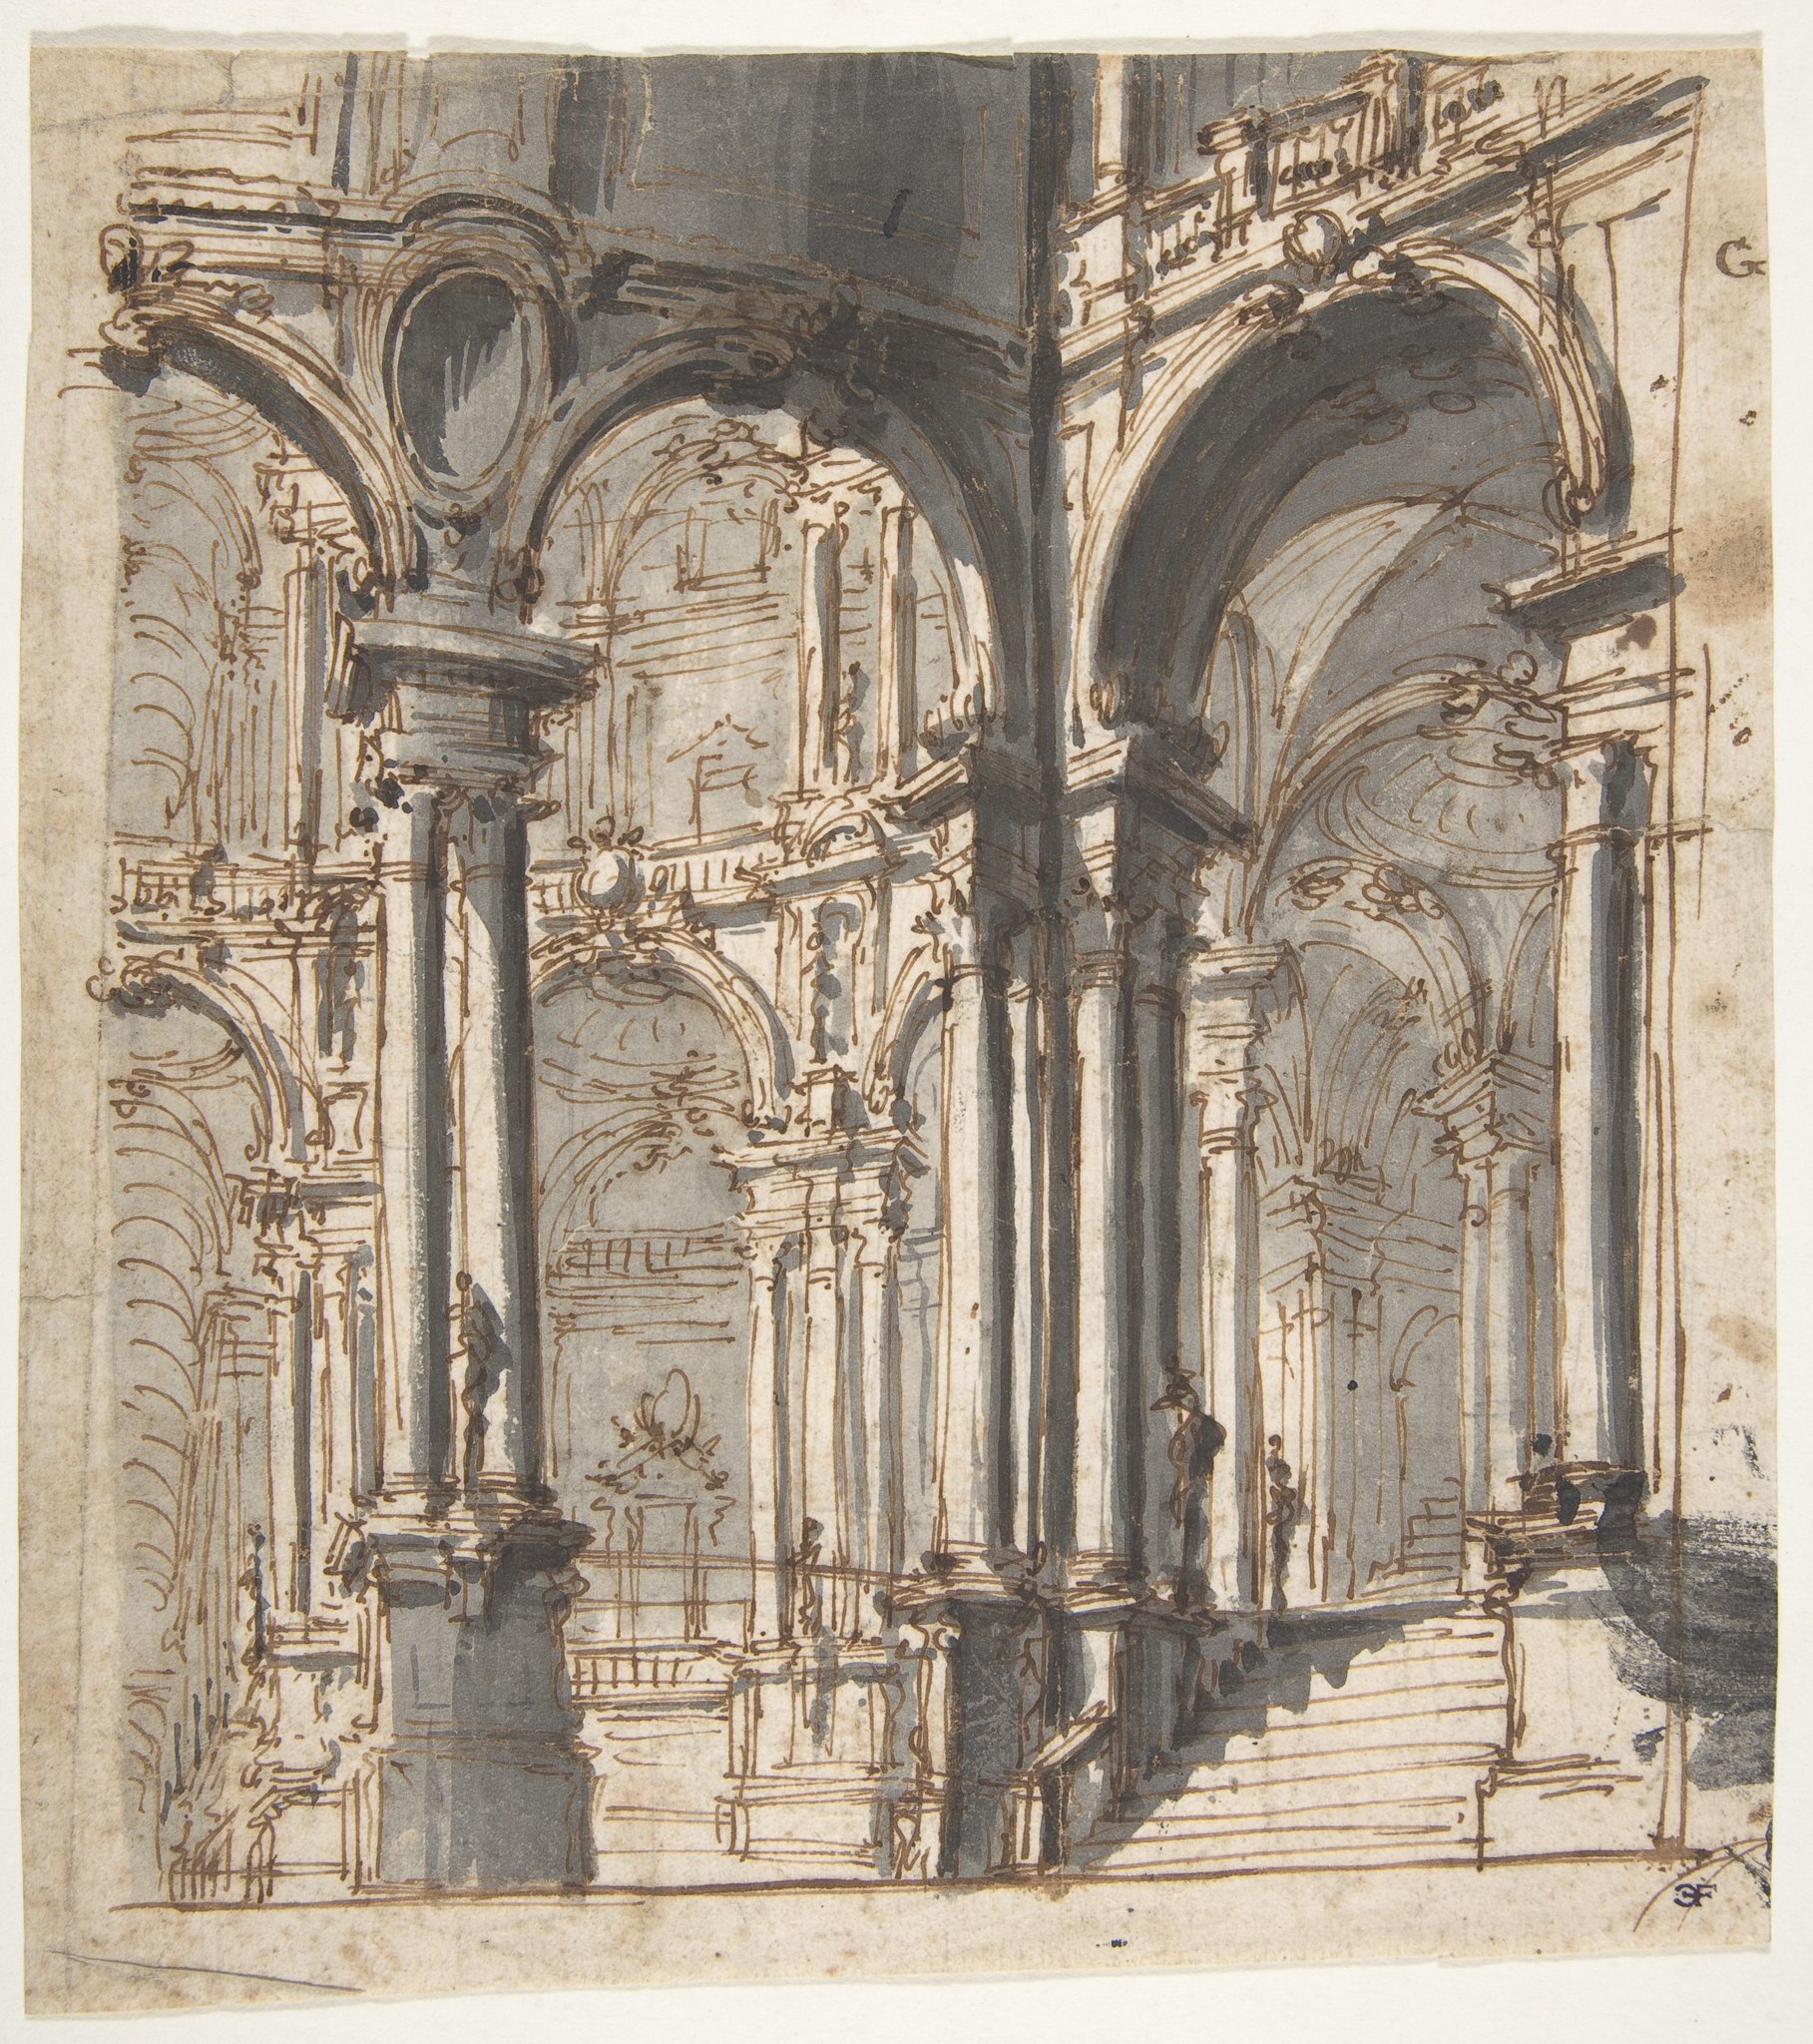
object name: drawing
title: Design for Stage Set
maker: giovanni battista natali iii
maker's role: artist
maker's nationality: italian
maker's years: 1698-1765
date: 1698-1765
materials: ink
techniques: brush, pen, wash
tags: columns,stage design